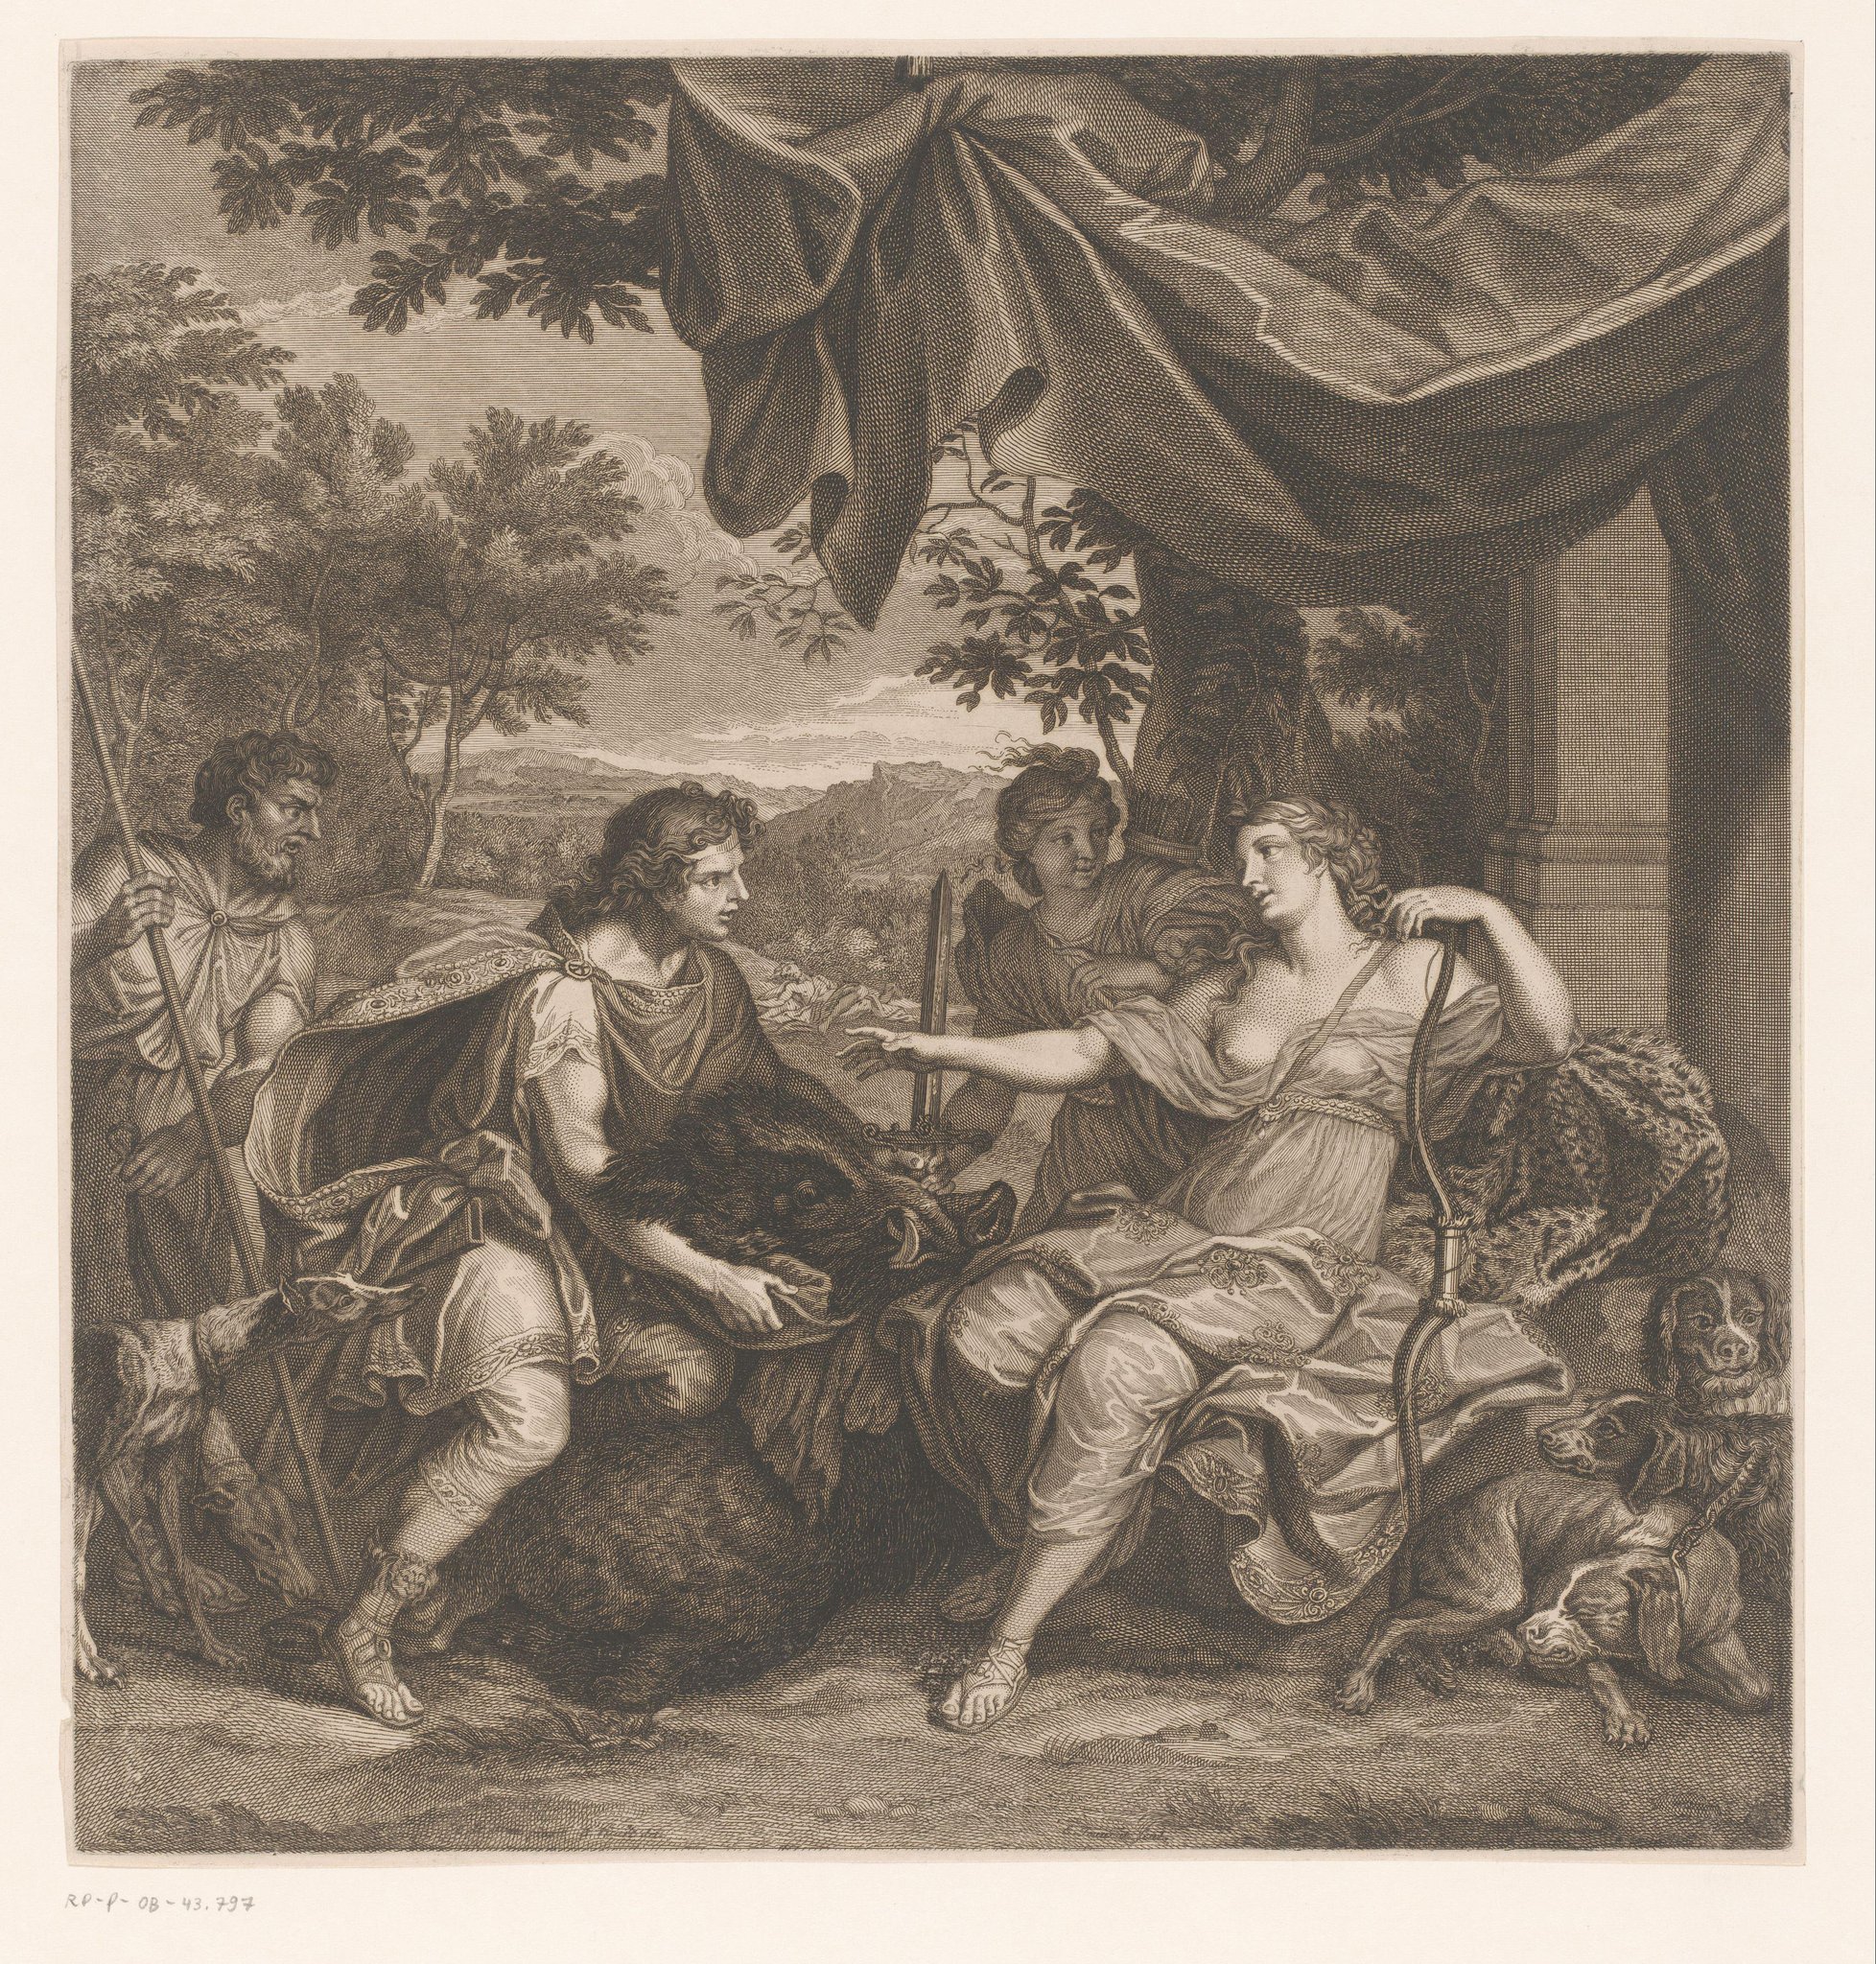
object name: print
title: Meleager en Atalante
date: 1698-1738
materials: paper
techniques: engraving, etching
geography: france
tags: meleager gives the head of the boar to atalanta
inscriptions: collector's mark: Lugt 240